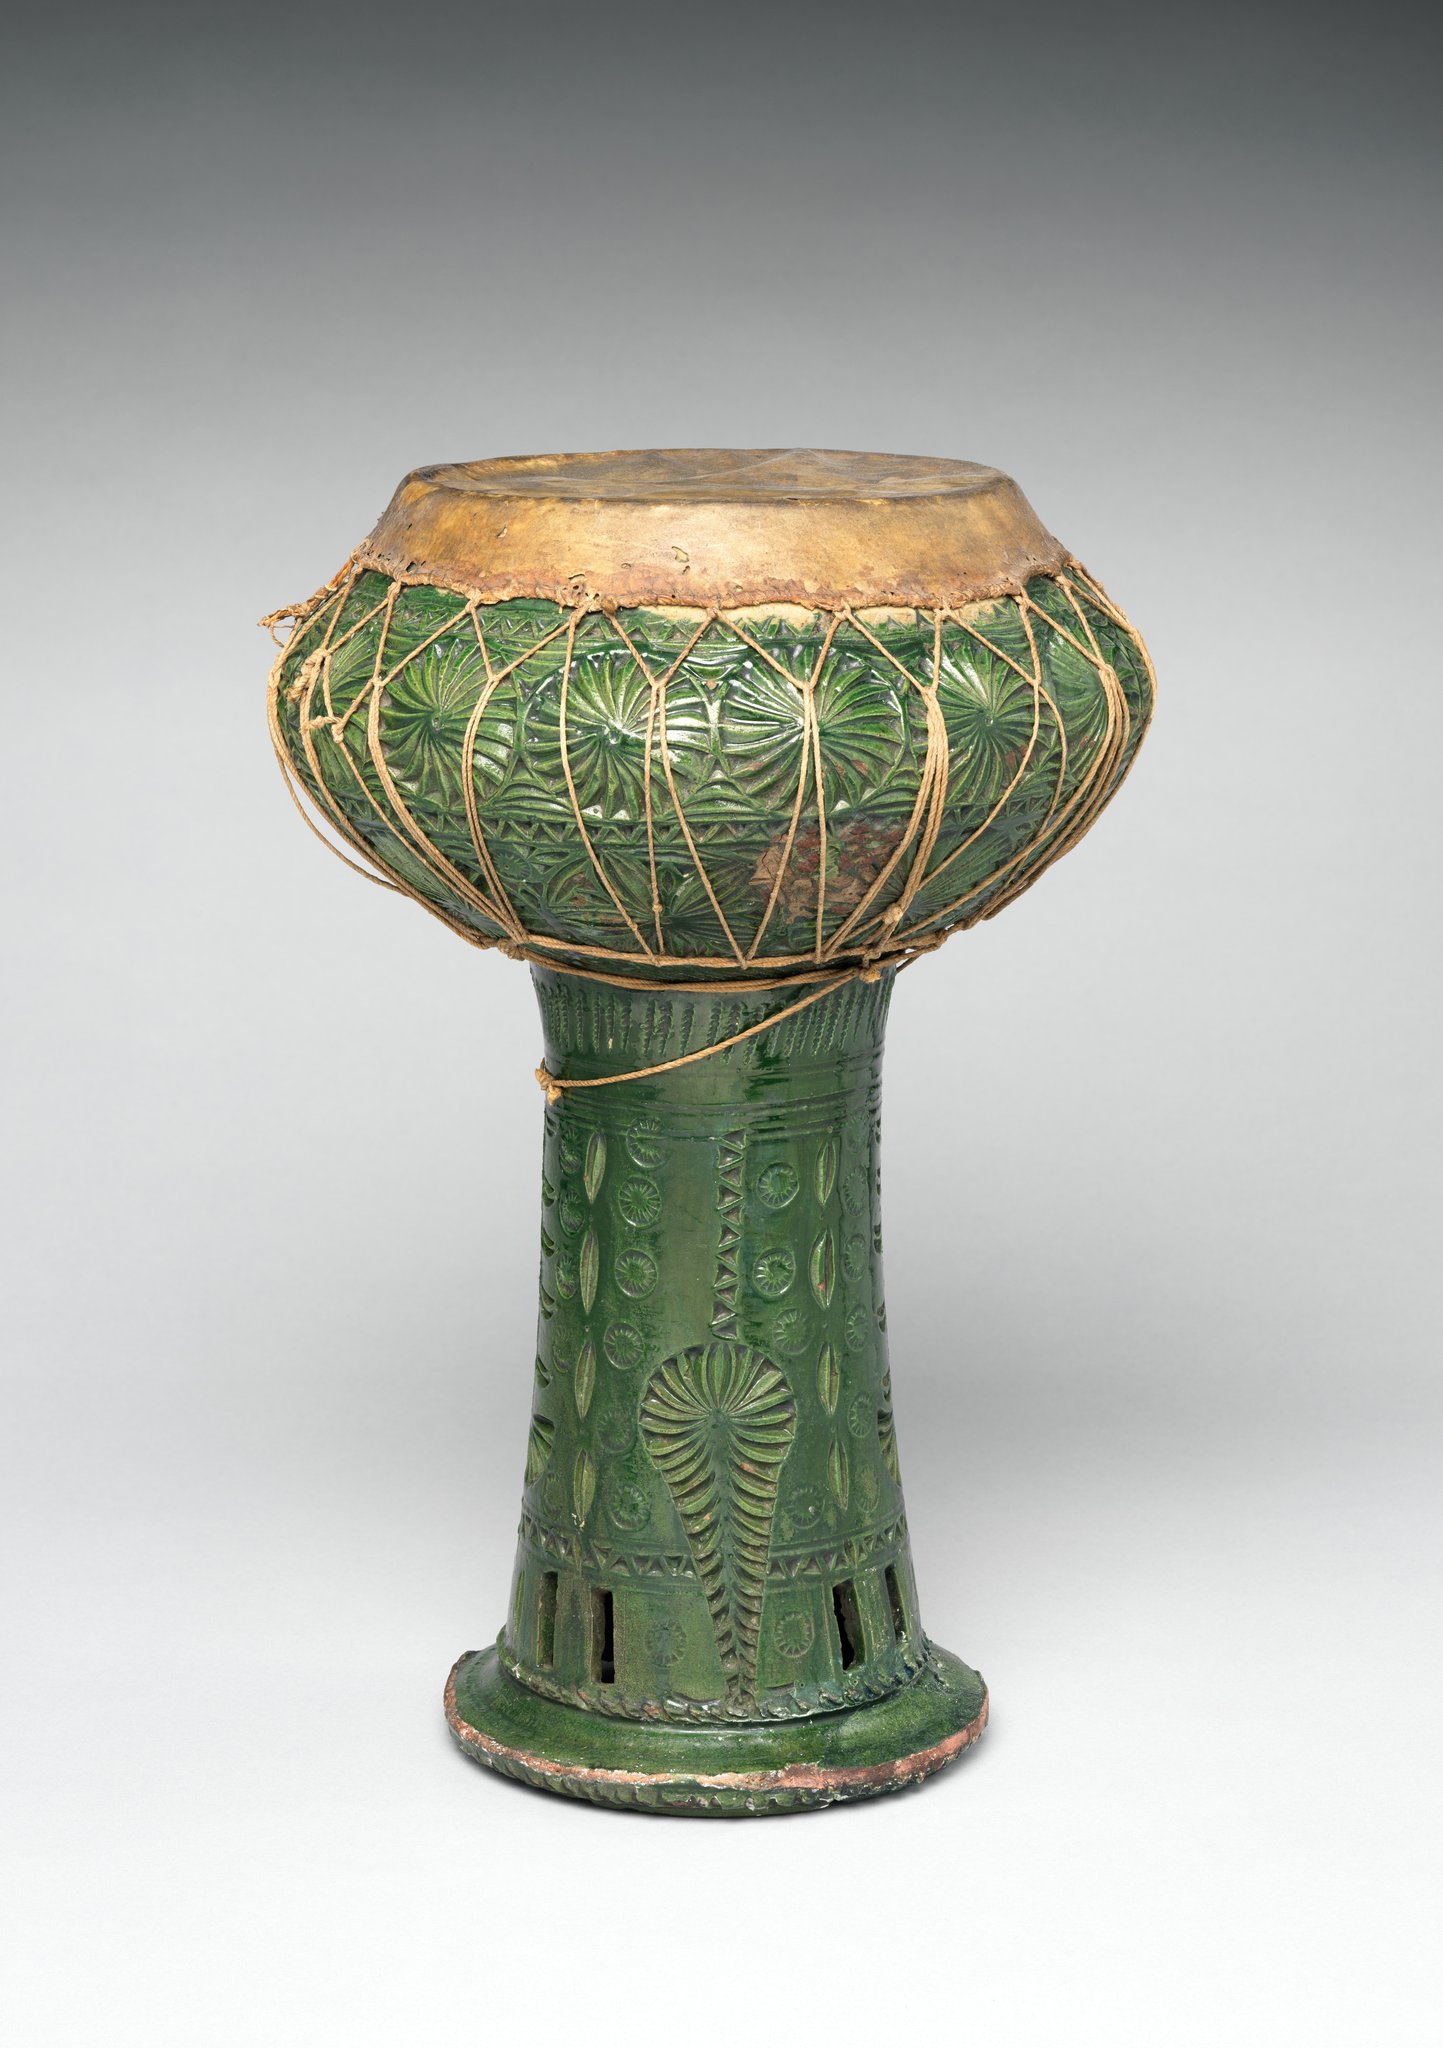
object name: darabukka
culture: middle eastern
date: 1867-1900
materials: clay, skin, wood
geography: syria